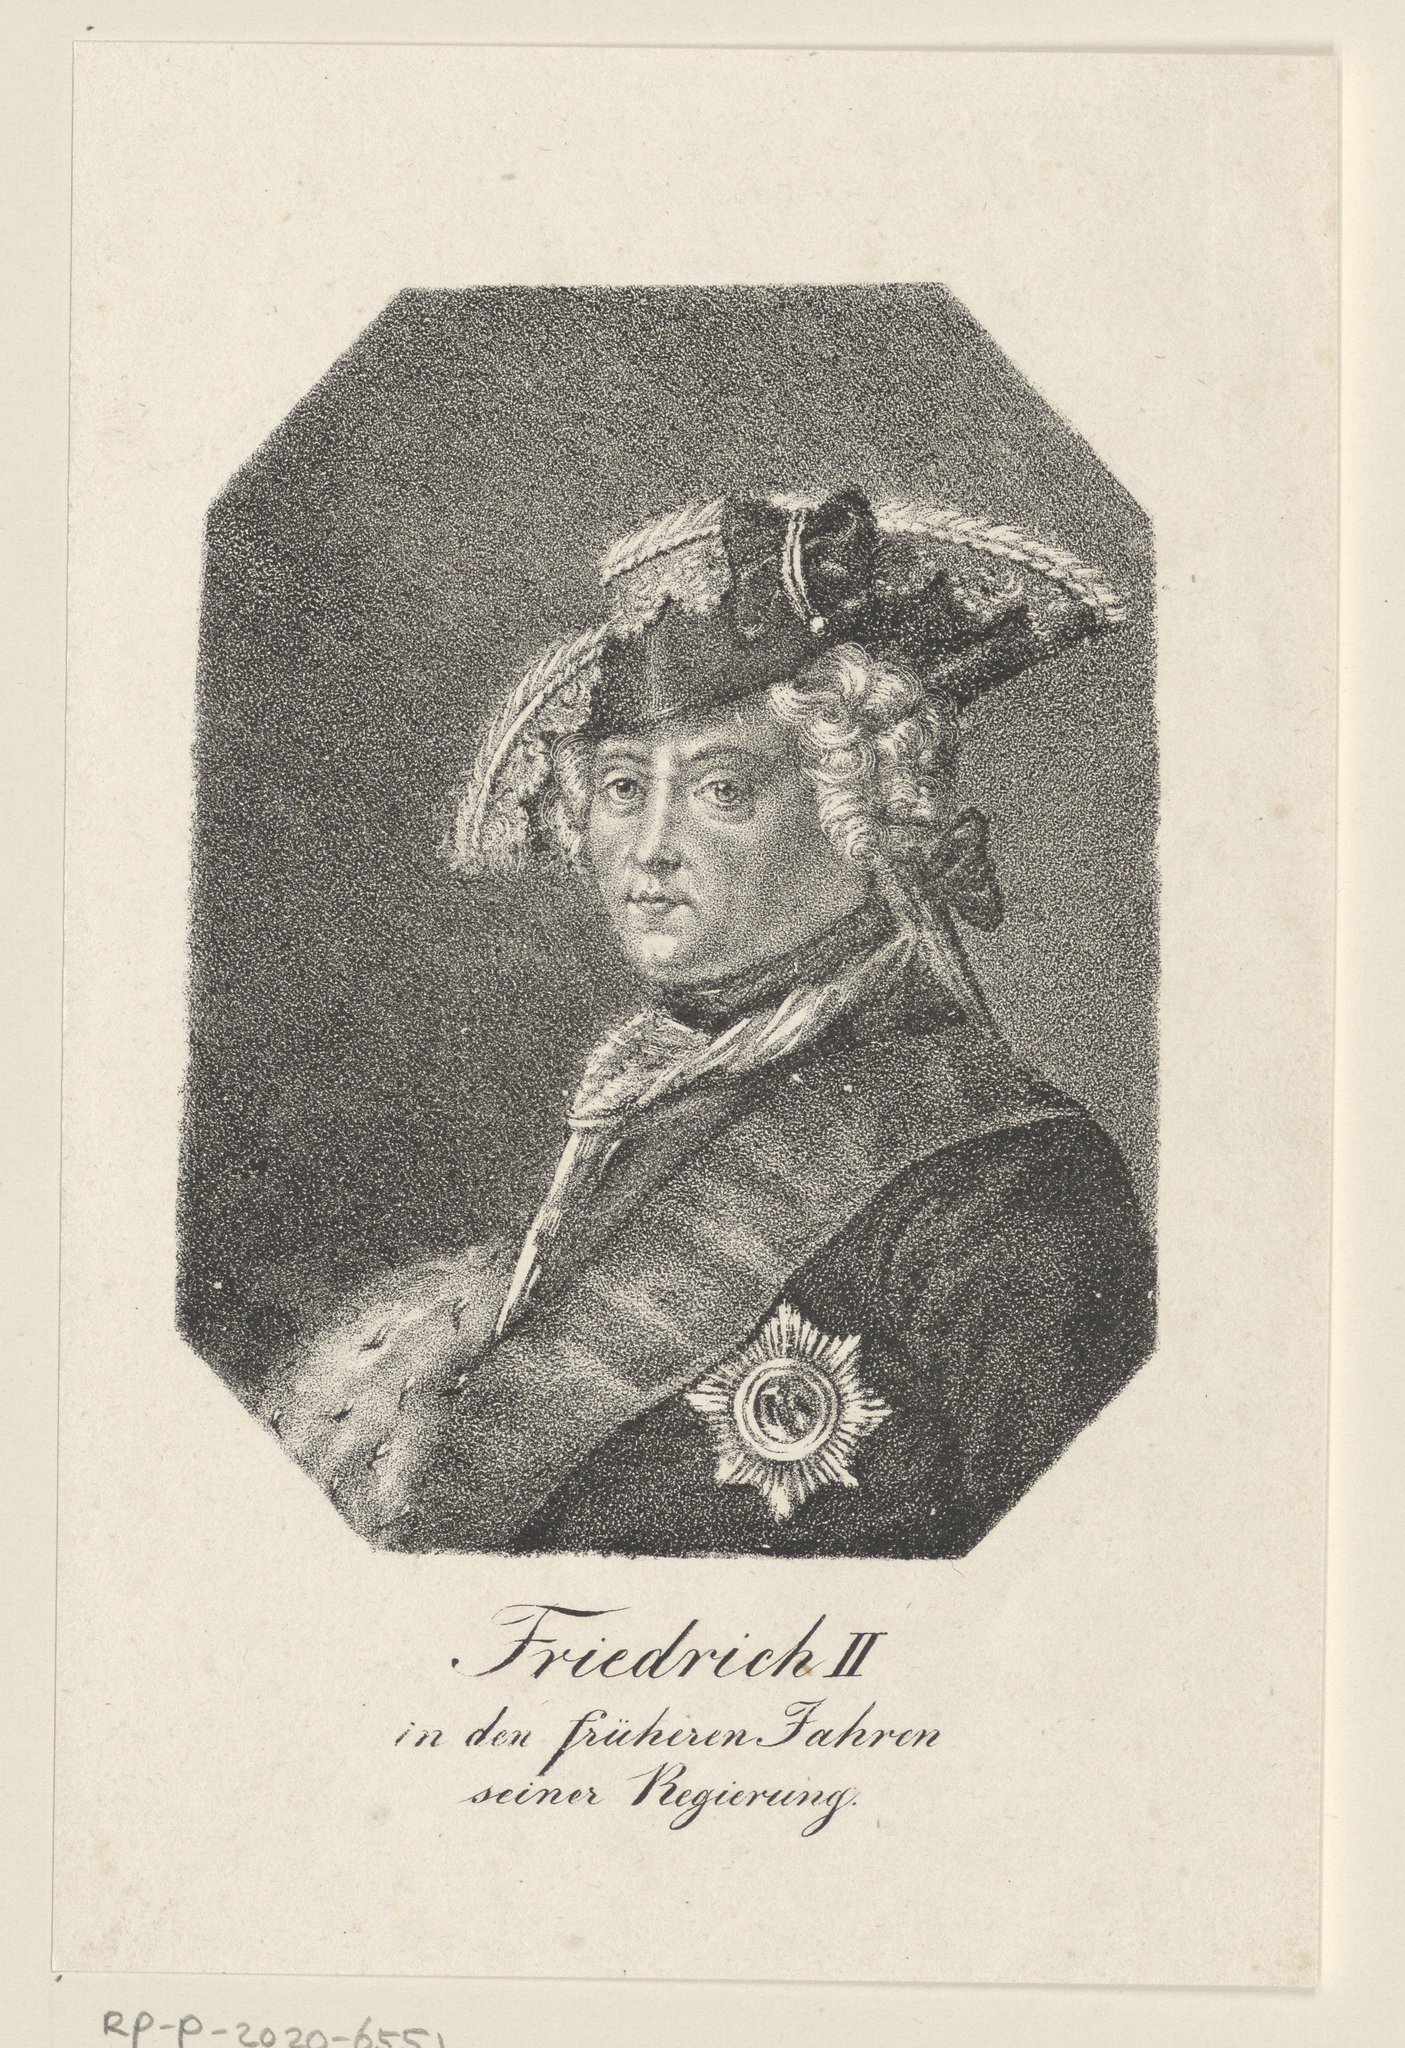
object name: print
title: Portret van Frederik de Grote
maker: Anonymous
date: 1800-1850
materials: paper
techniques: lithograph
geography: germany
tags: berlin, frederick ii (king of prussia), historical persons, king